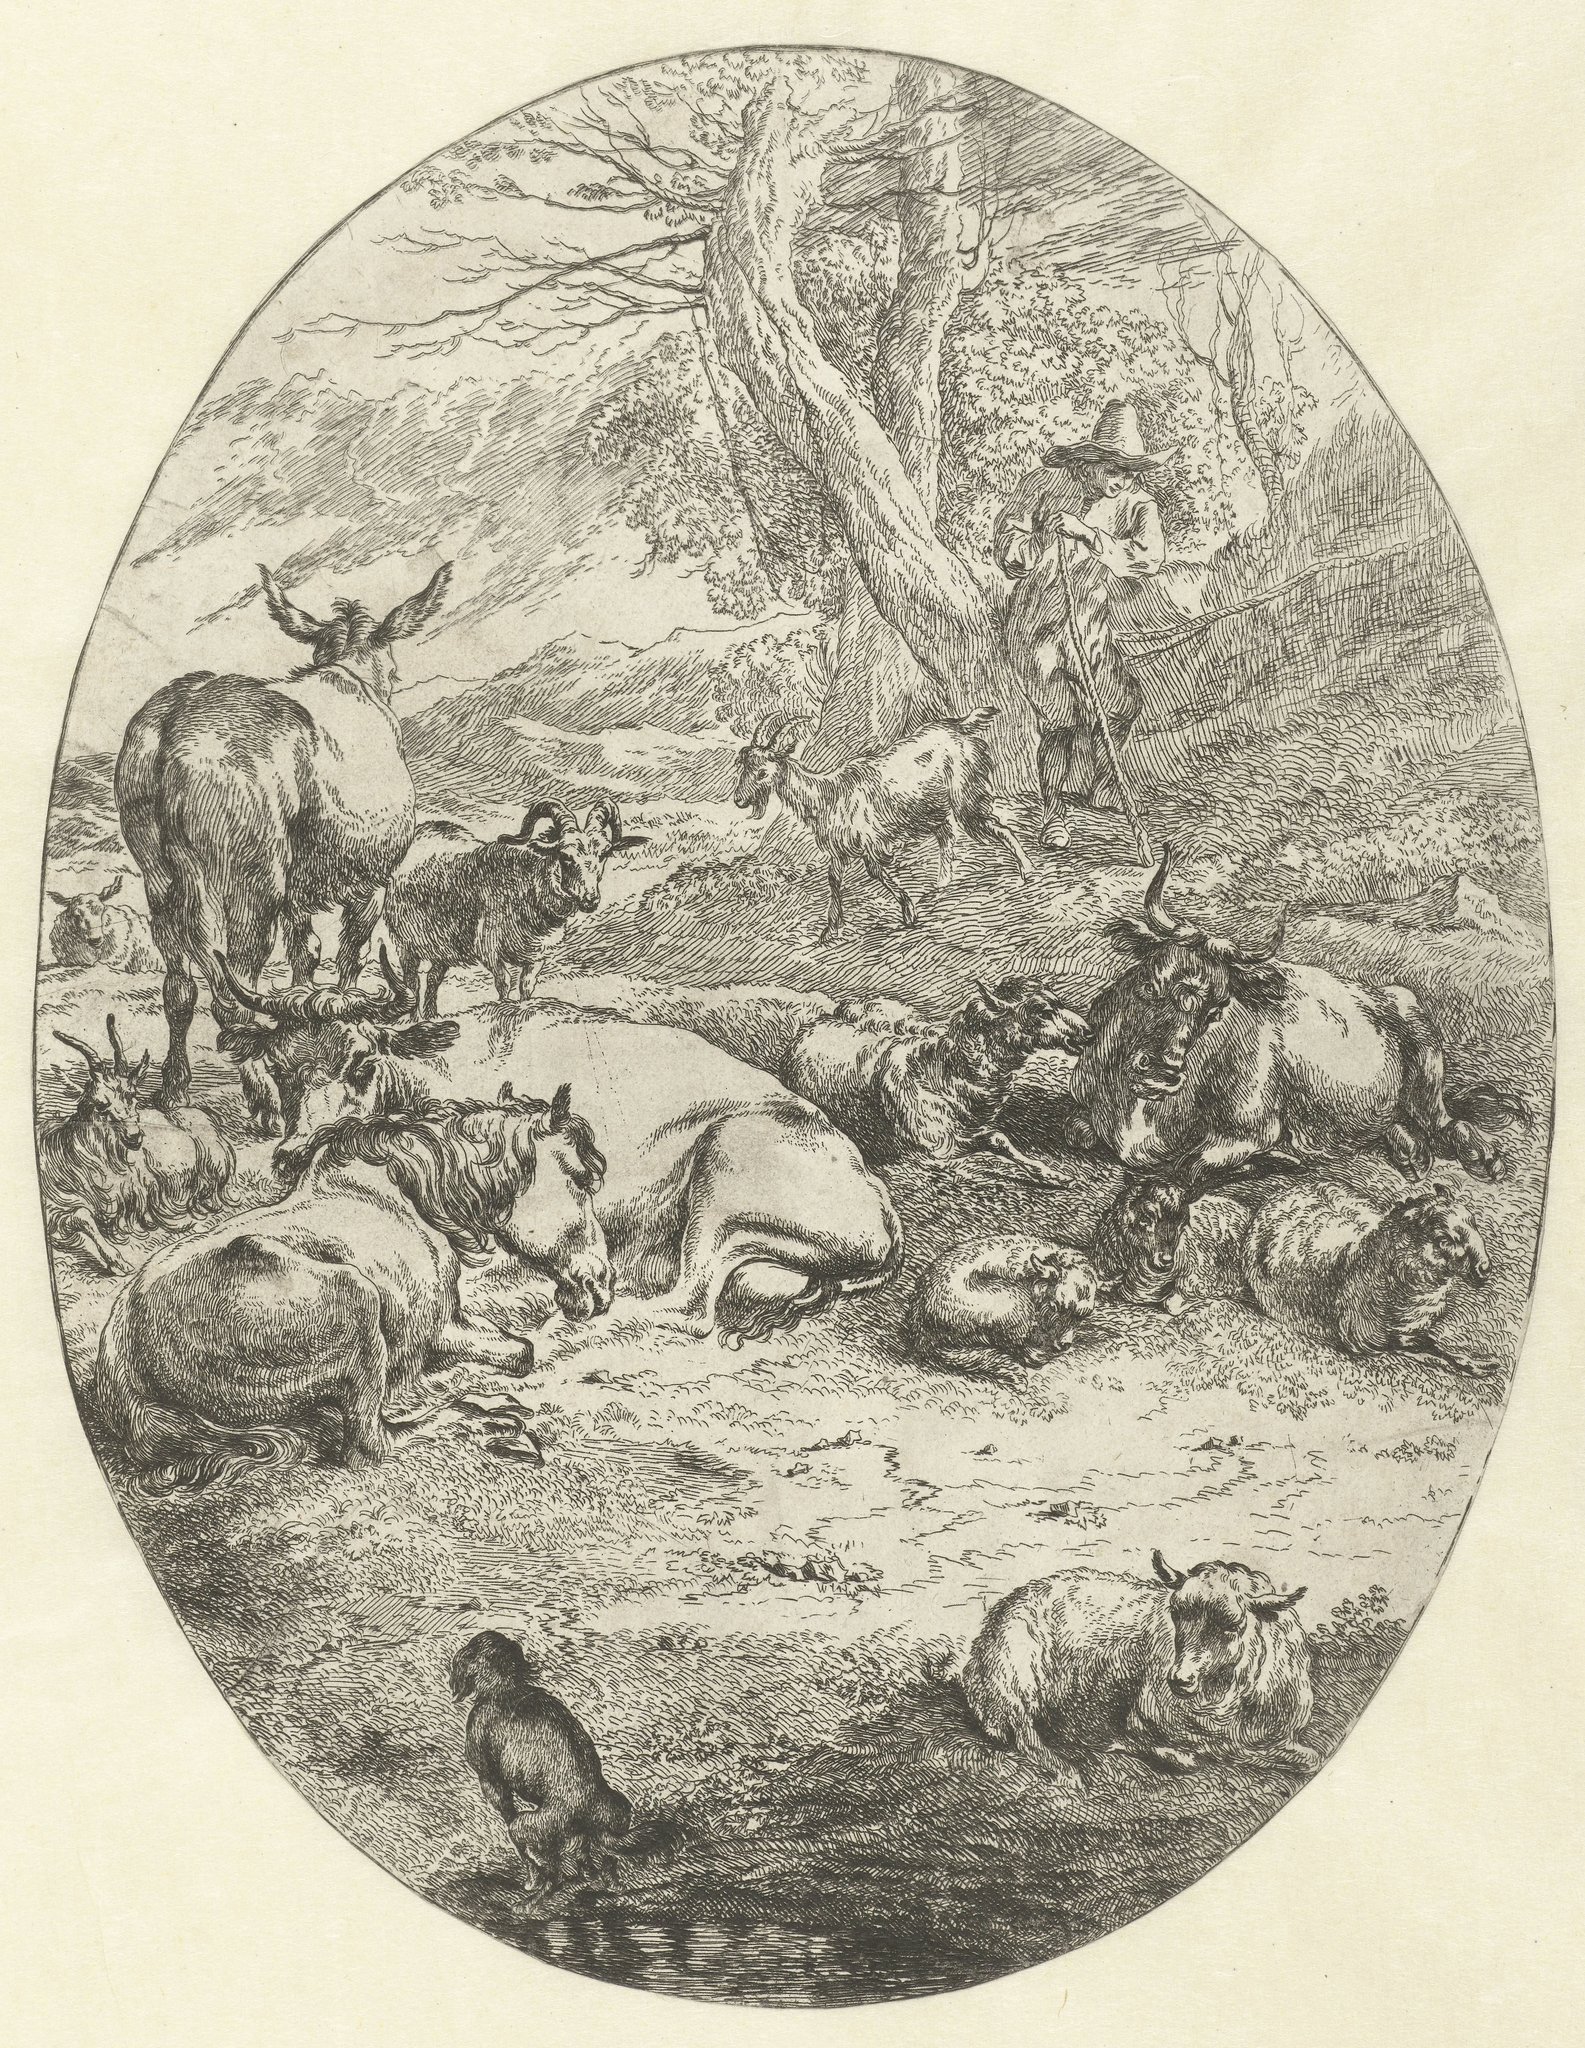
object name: print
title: Herder met vee rust bij twee bomen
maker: abraham jansz begeyn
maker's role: draughtsman, print maker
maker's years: 1637-1697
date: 1647-1697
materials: paper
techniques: etching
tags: herding, herdsman, herdswoman, shepherd, shepherdess, cowherd, etc., herd, flock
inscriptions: collector's mark: Lugt 2760, collector's mark: Lugt 2228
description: Herder met vee rust bij twee bomen en op voorgrond zit een poepende hond bij drenkplaats. Prent in ovaal kader.